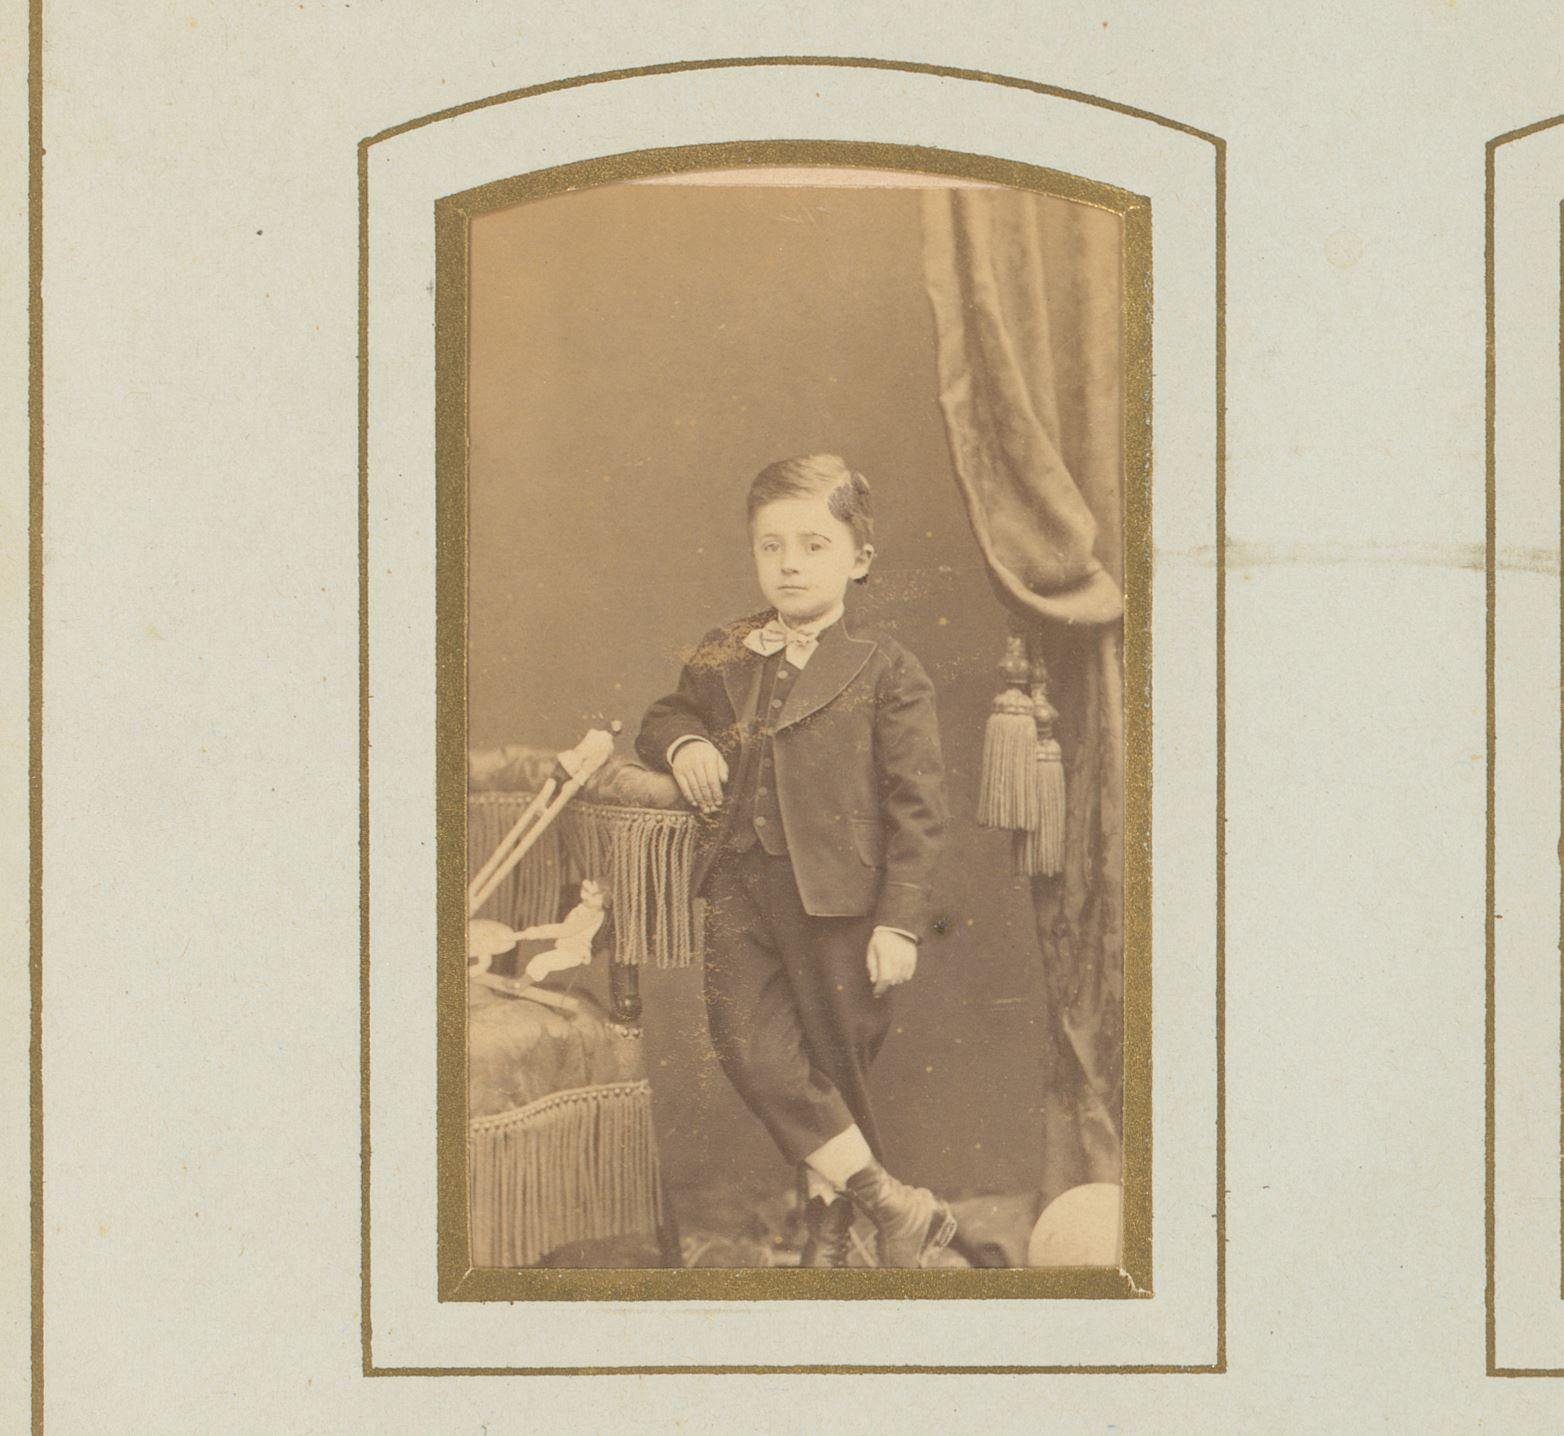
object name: photograph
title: Portret van een jongen, leunend op een stoel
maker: louis delaporte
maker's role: fotograaf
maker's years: 1823-1890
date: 1875-1900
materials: cardboard, photographic support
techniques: albumen print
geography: vincennes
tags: boy (child between toddler and youth), historical persons, chair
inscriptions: inscription: ‘Photographie/ du Cours Marigny/ Delaporte/ Vincennes/ [25, Cours Marigny et Rue du Terrier, 28.]’